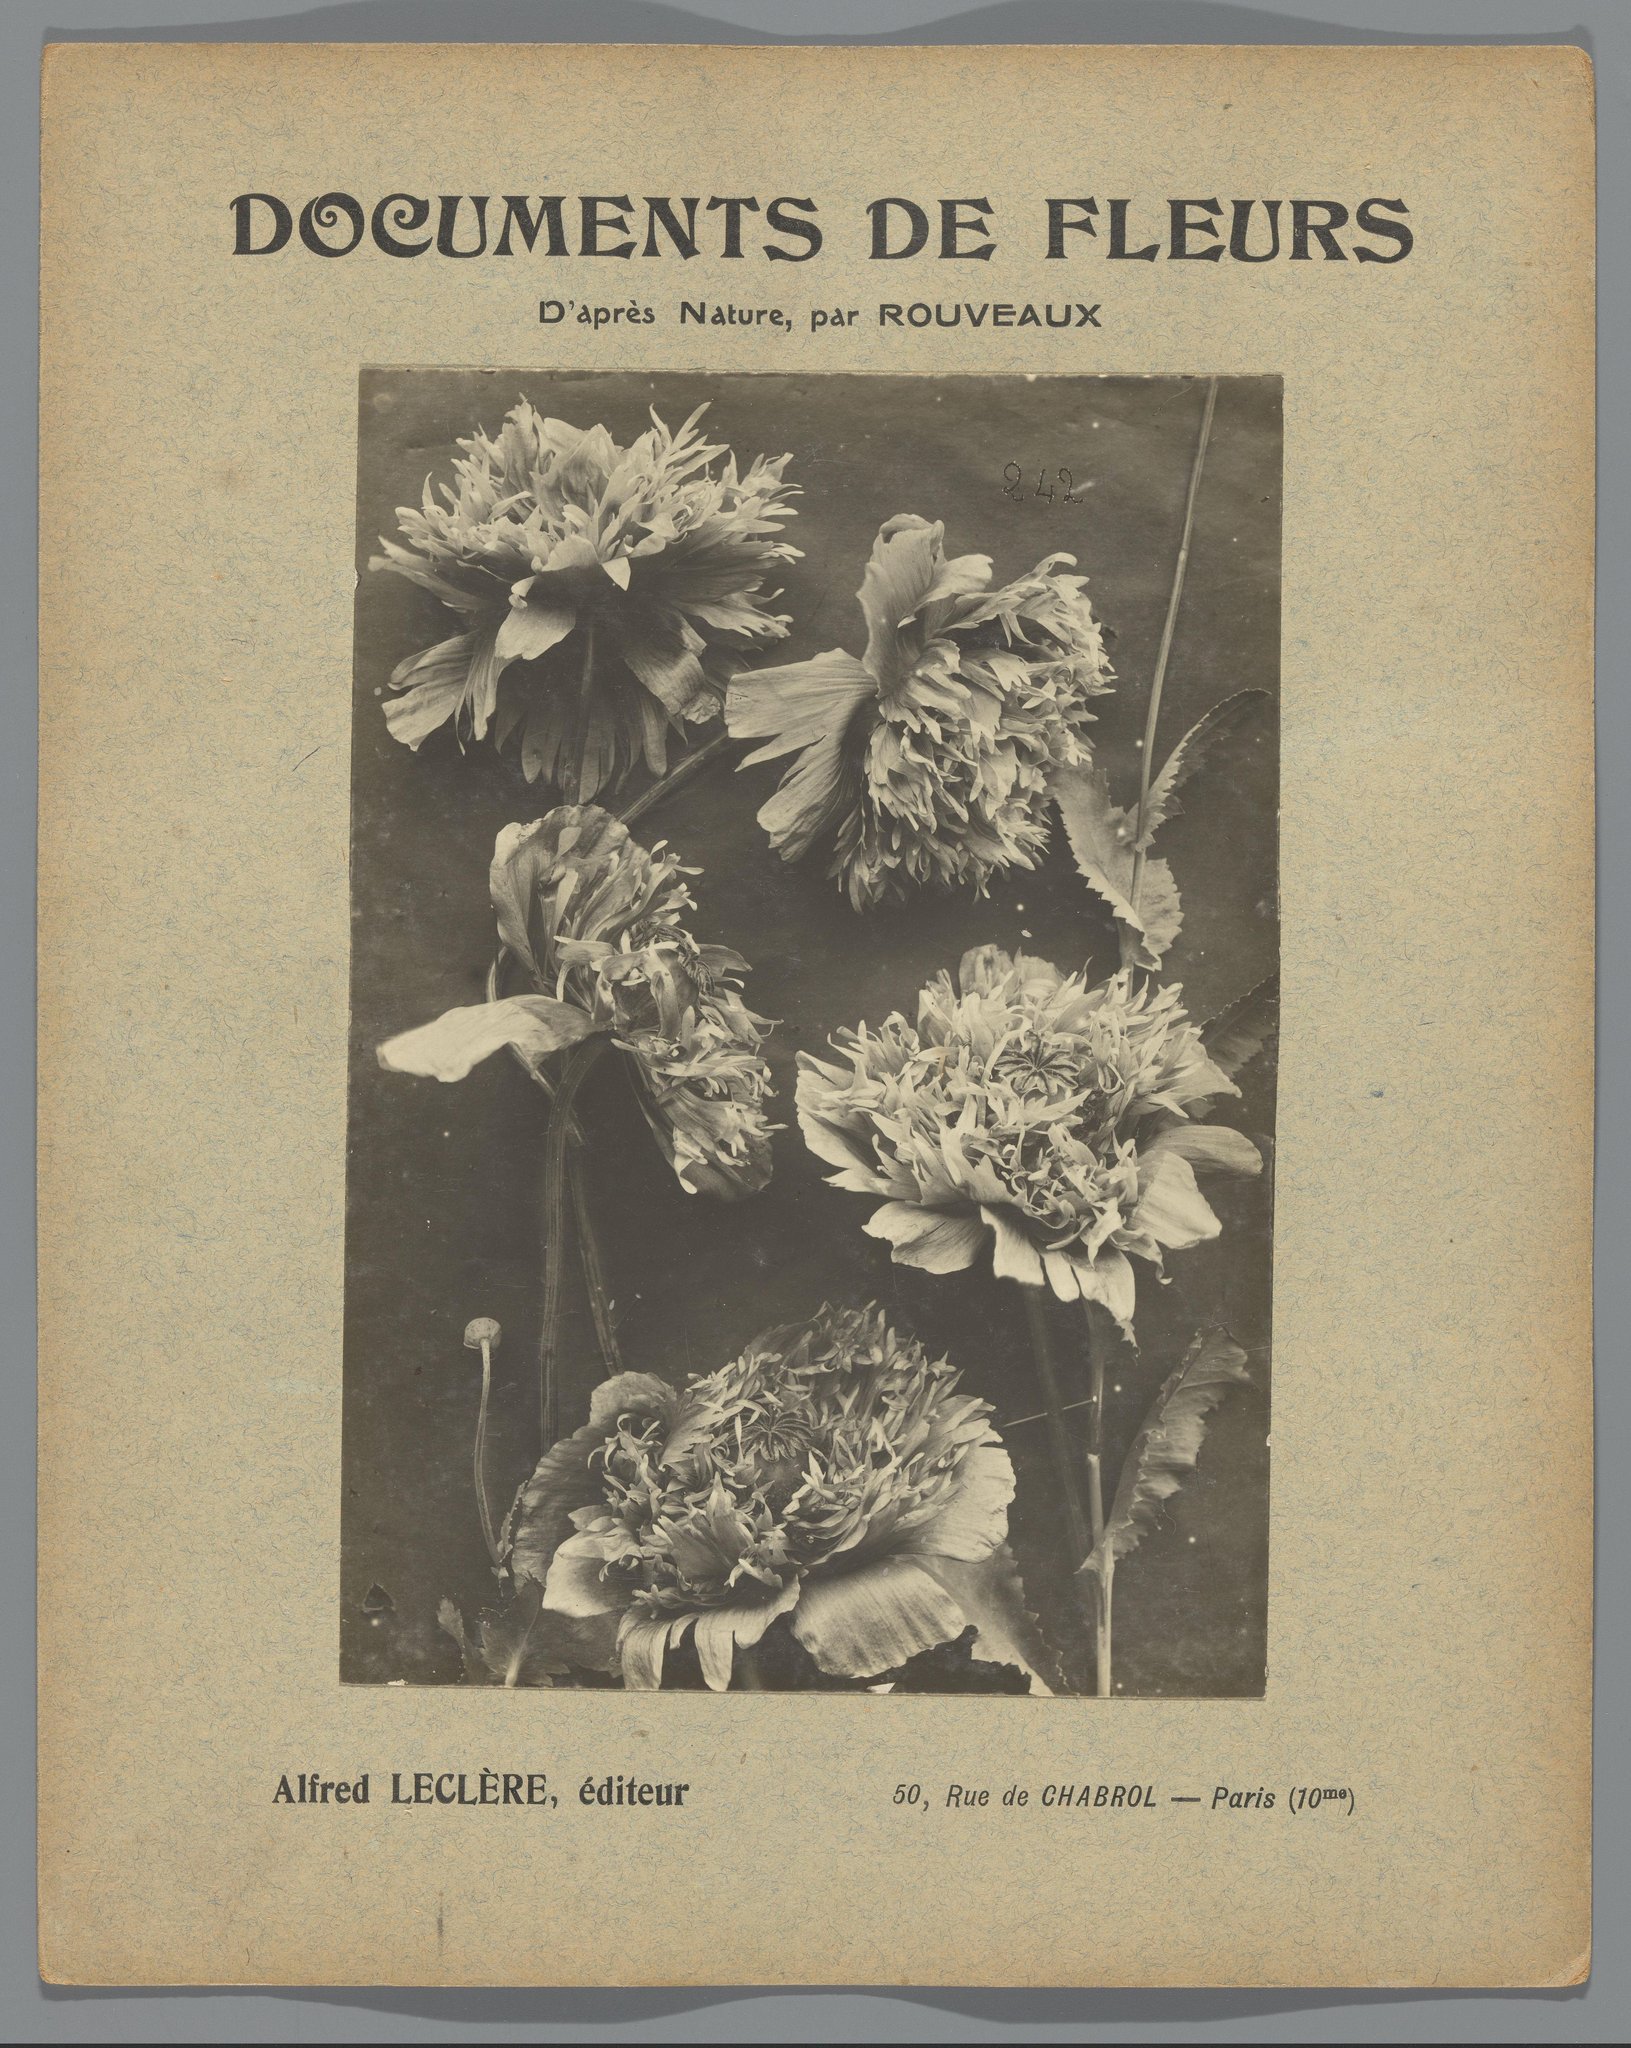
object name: photograph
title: Bloemstudie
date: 1895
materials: photographic support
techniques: gelatin silver print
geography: france